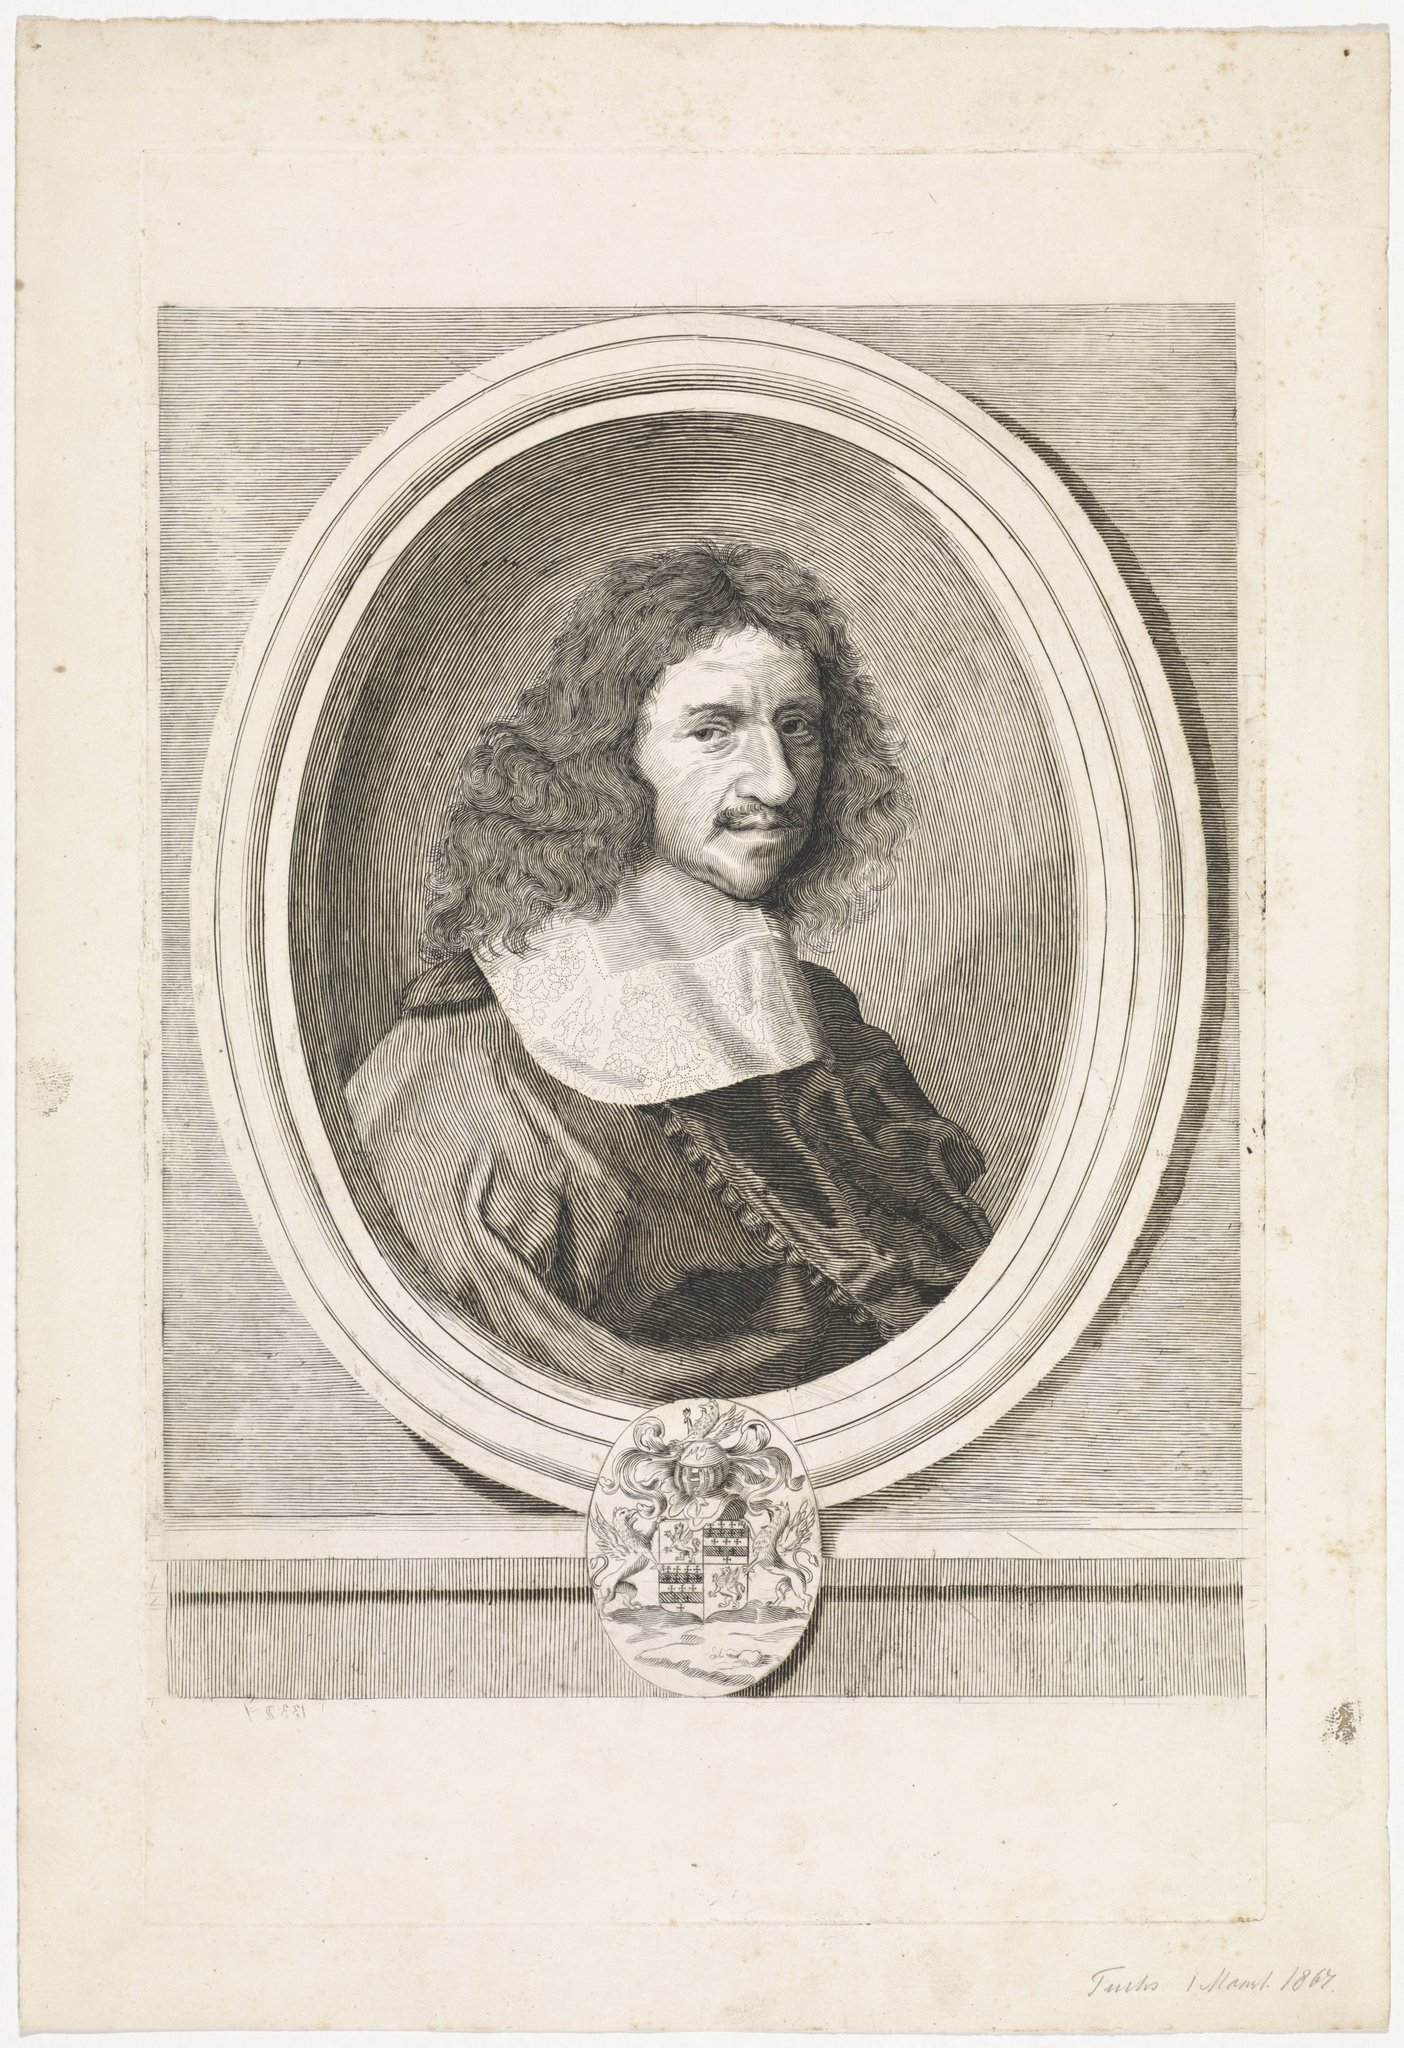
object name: print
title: Portret van een man in ovaal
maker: c.a. tuchs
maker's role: print maker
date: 1867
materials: paper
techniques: engraving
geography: netherlands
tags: armorial bearing, heraldry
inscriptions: inscription: ‘Tuchs 1 Maart 1867.’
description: Portret van een man met een platte kraag in een ovaal. Midden onder zijn wapenschild geflankeerd door griffioenen en bekroond met een helm en griffioen.